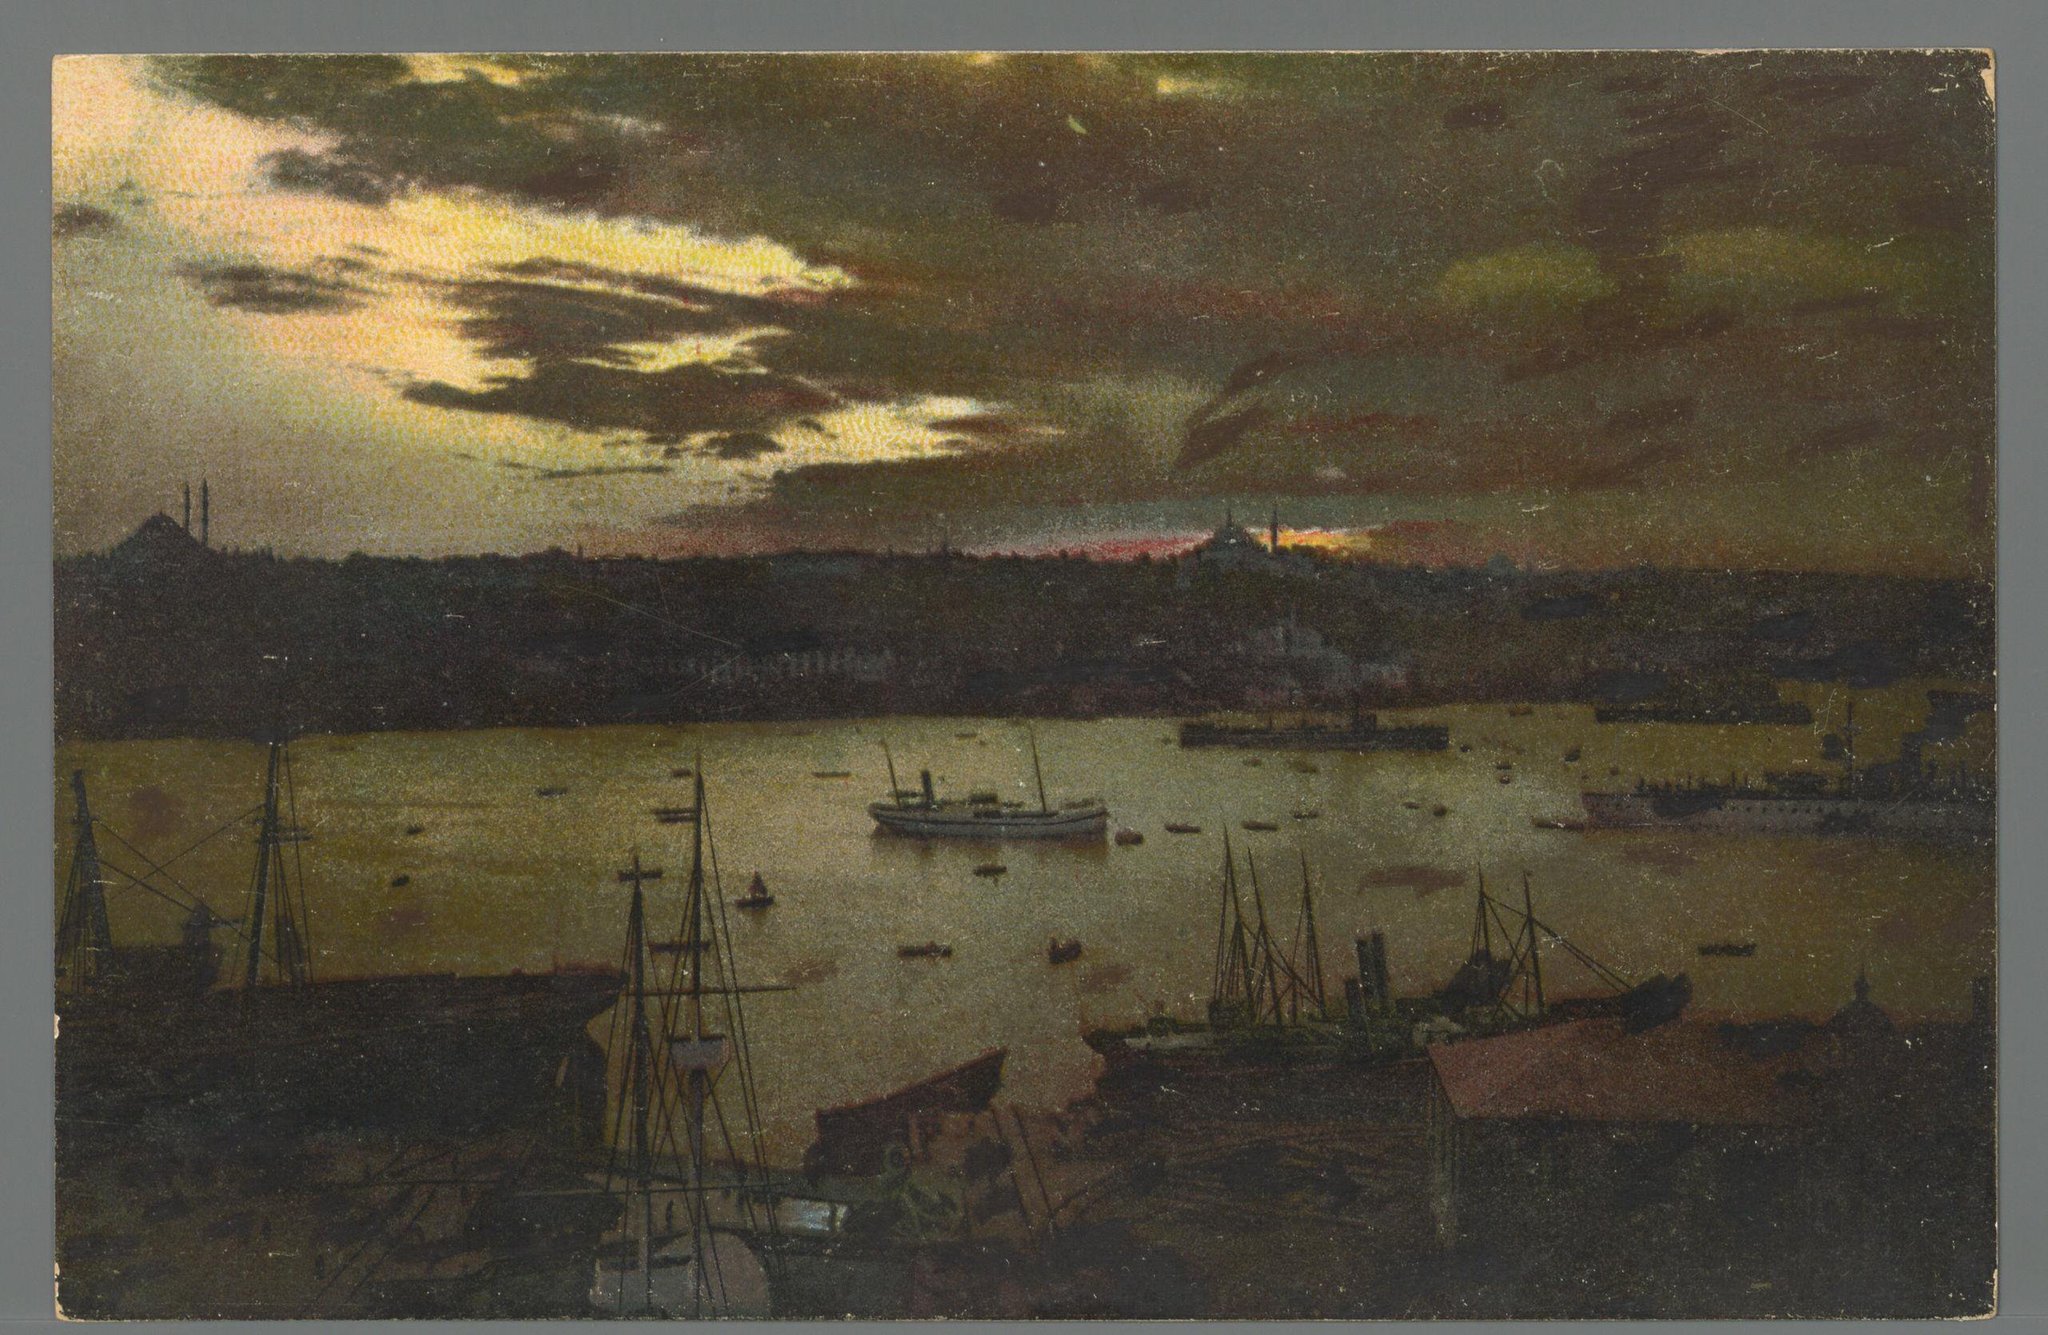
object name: photomechanical print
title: Constantinople. La Corne d'Or au crépuscule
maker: Anonymous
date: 1906-1920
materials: cardboard, photographic process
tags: dusk, evening twilight, ships (in general), prospect of city, town panorama, silhouette of city (+ city(-scape) with figures, staffage)